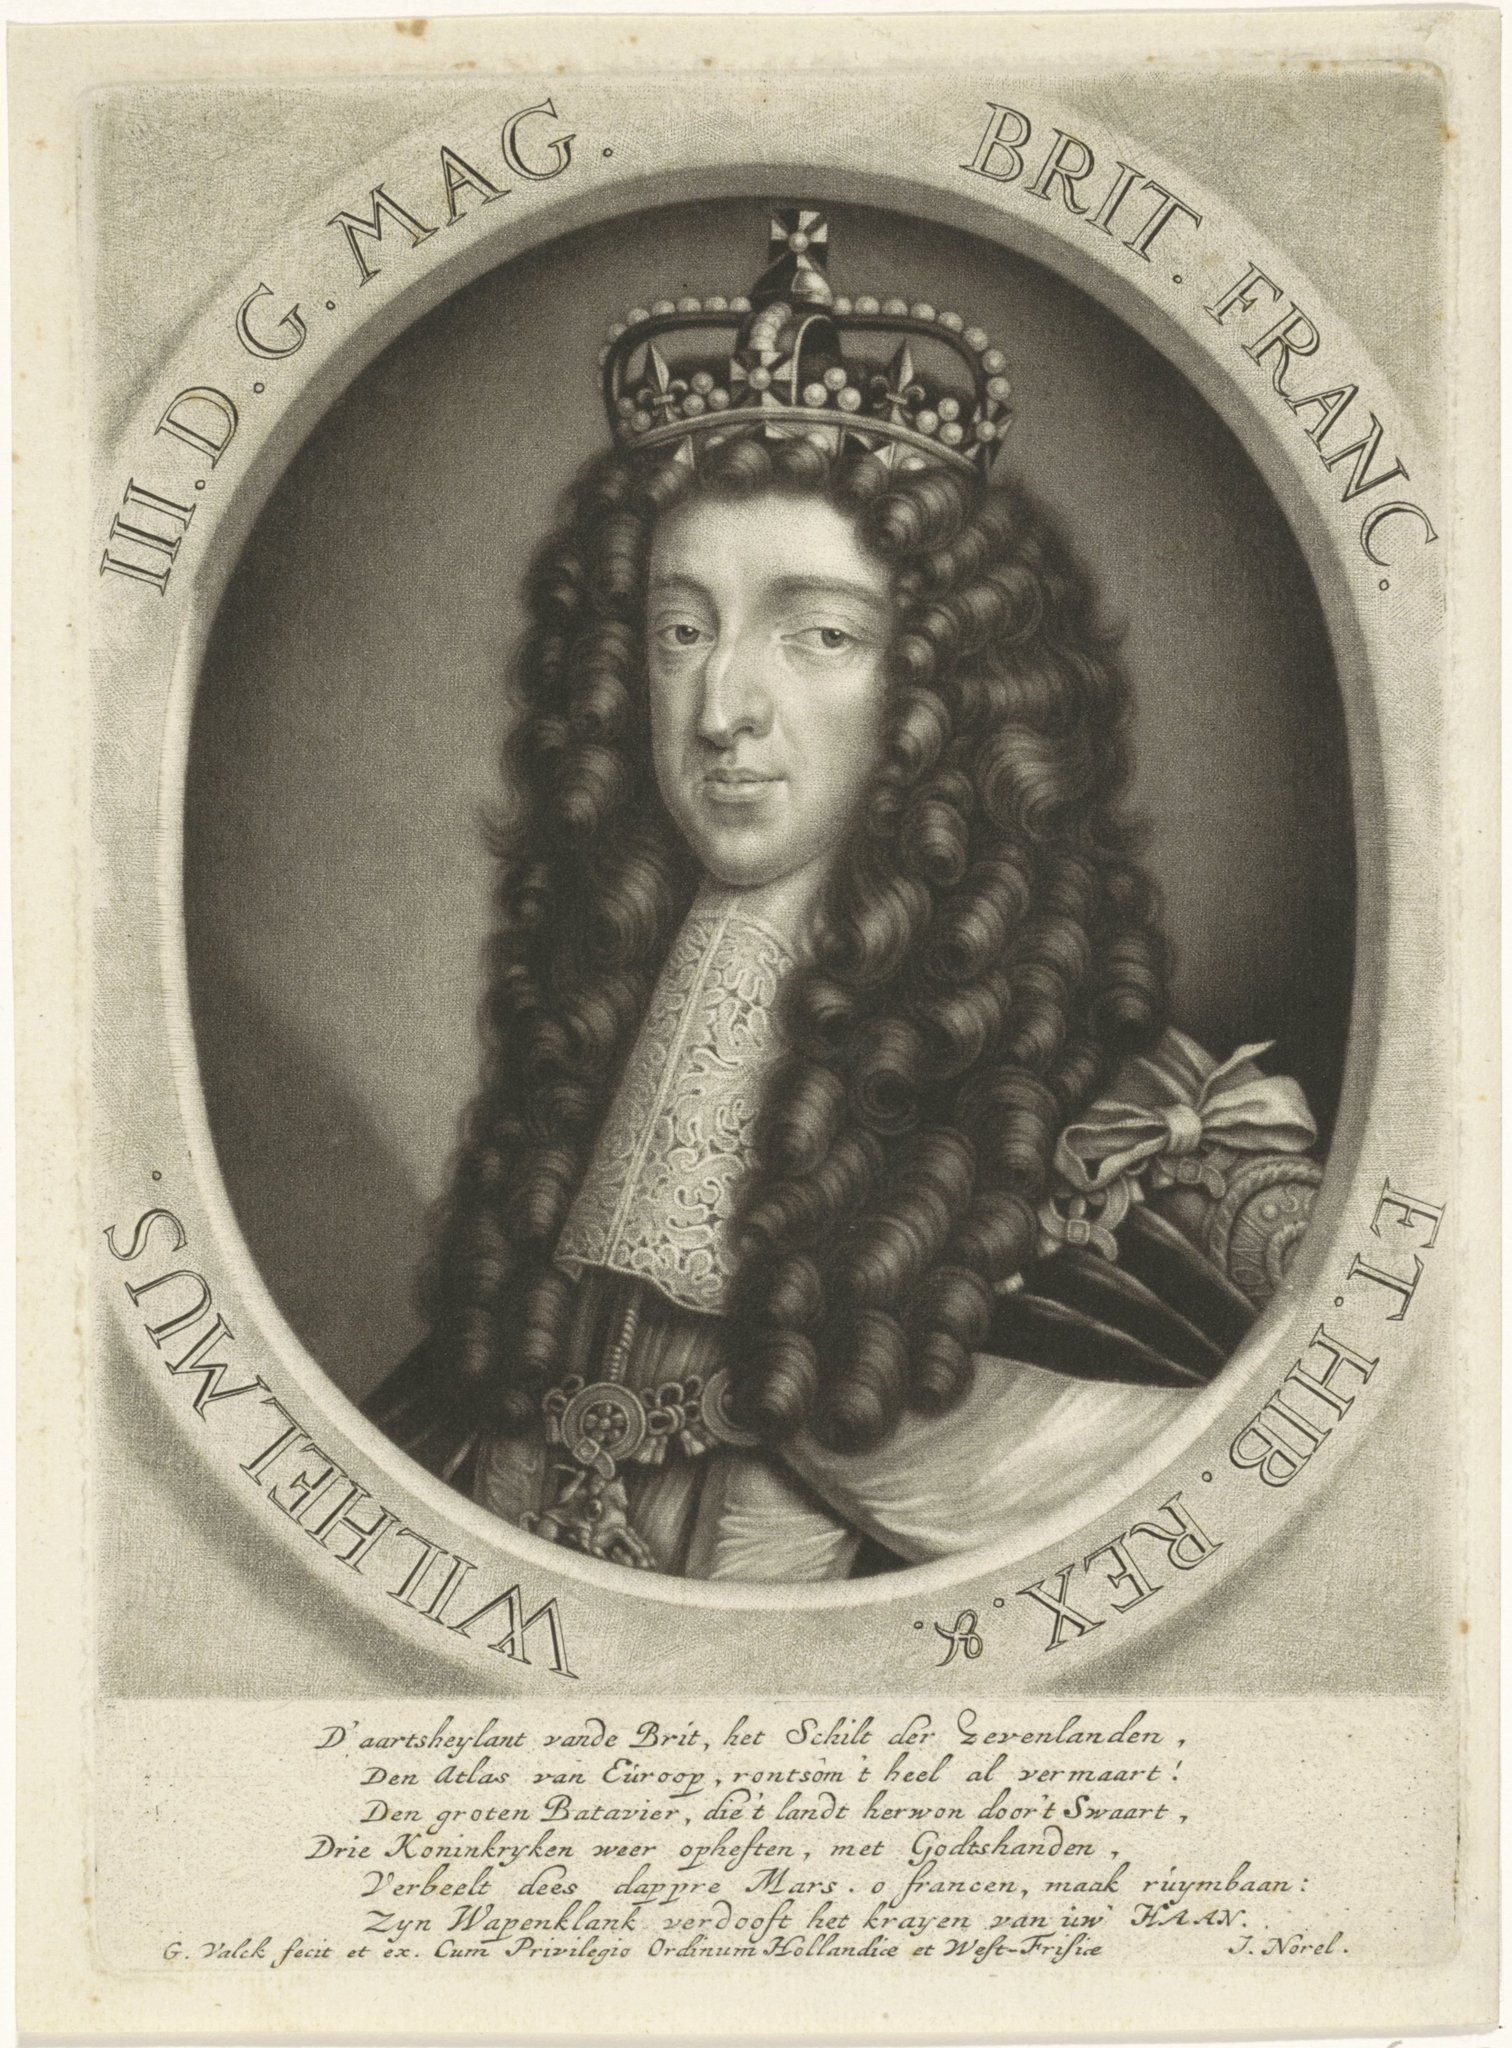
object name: print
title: Portret van Willem III, prins van Oranje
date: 1688-1726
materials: paper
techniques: mezzotint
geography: amsterdam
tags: william iii (prince of orange and king of england, scotland, and ireland), knighthood order (garter) - insignia of a knighthood order, e.g.: badge, chain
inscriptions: collector's mark: Lugt 963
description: De hier vermelde titel verwijst naar de hoogst verkregen titel van de geportretteerde, niet per se naar de titel die de geportretteerde op deze voorstelling draagt.